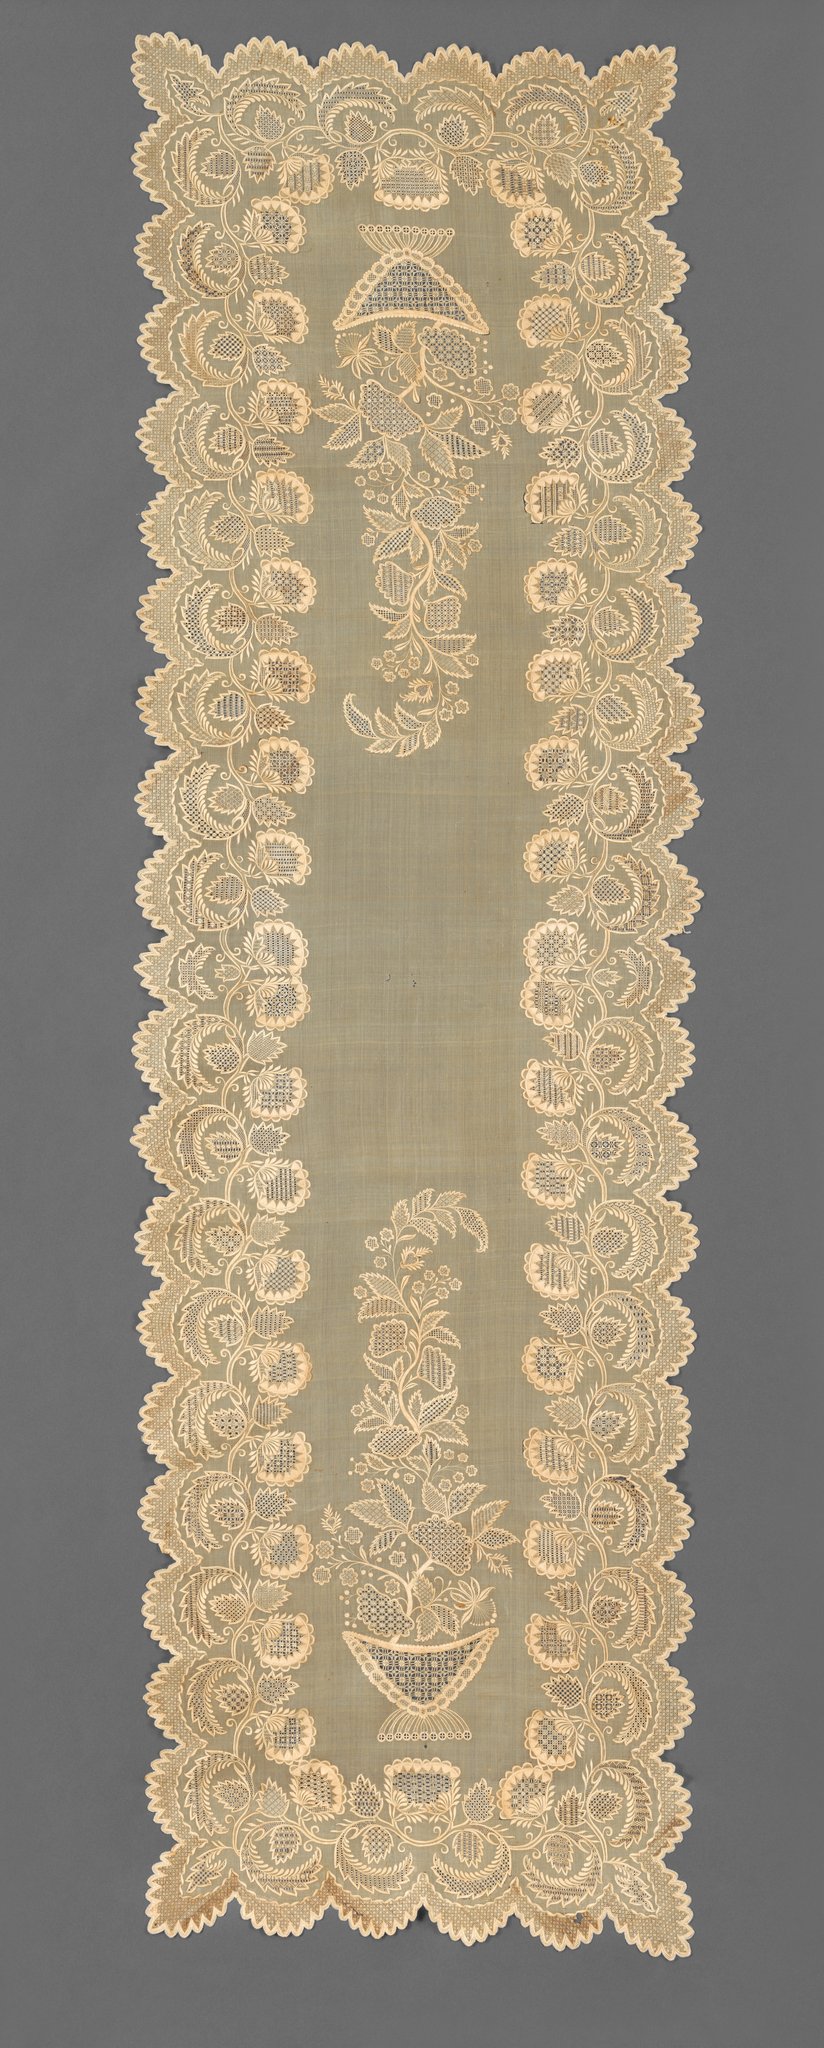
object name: cover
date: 1801-1900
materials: fiber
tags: flowers